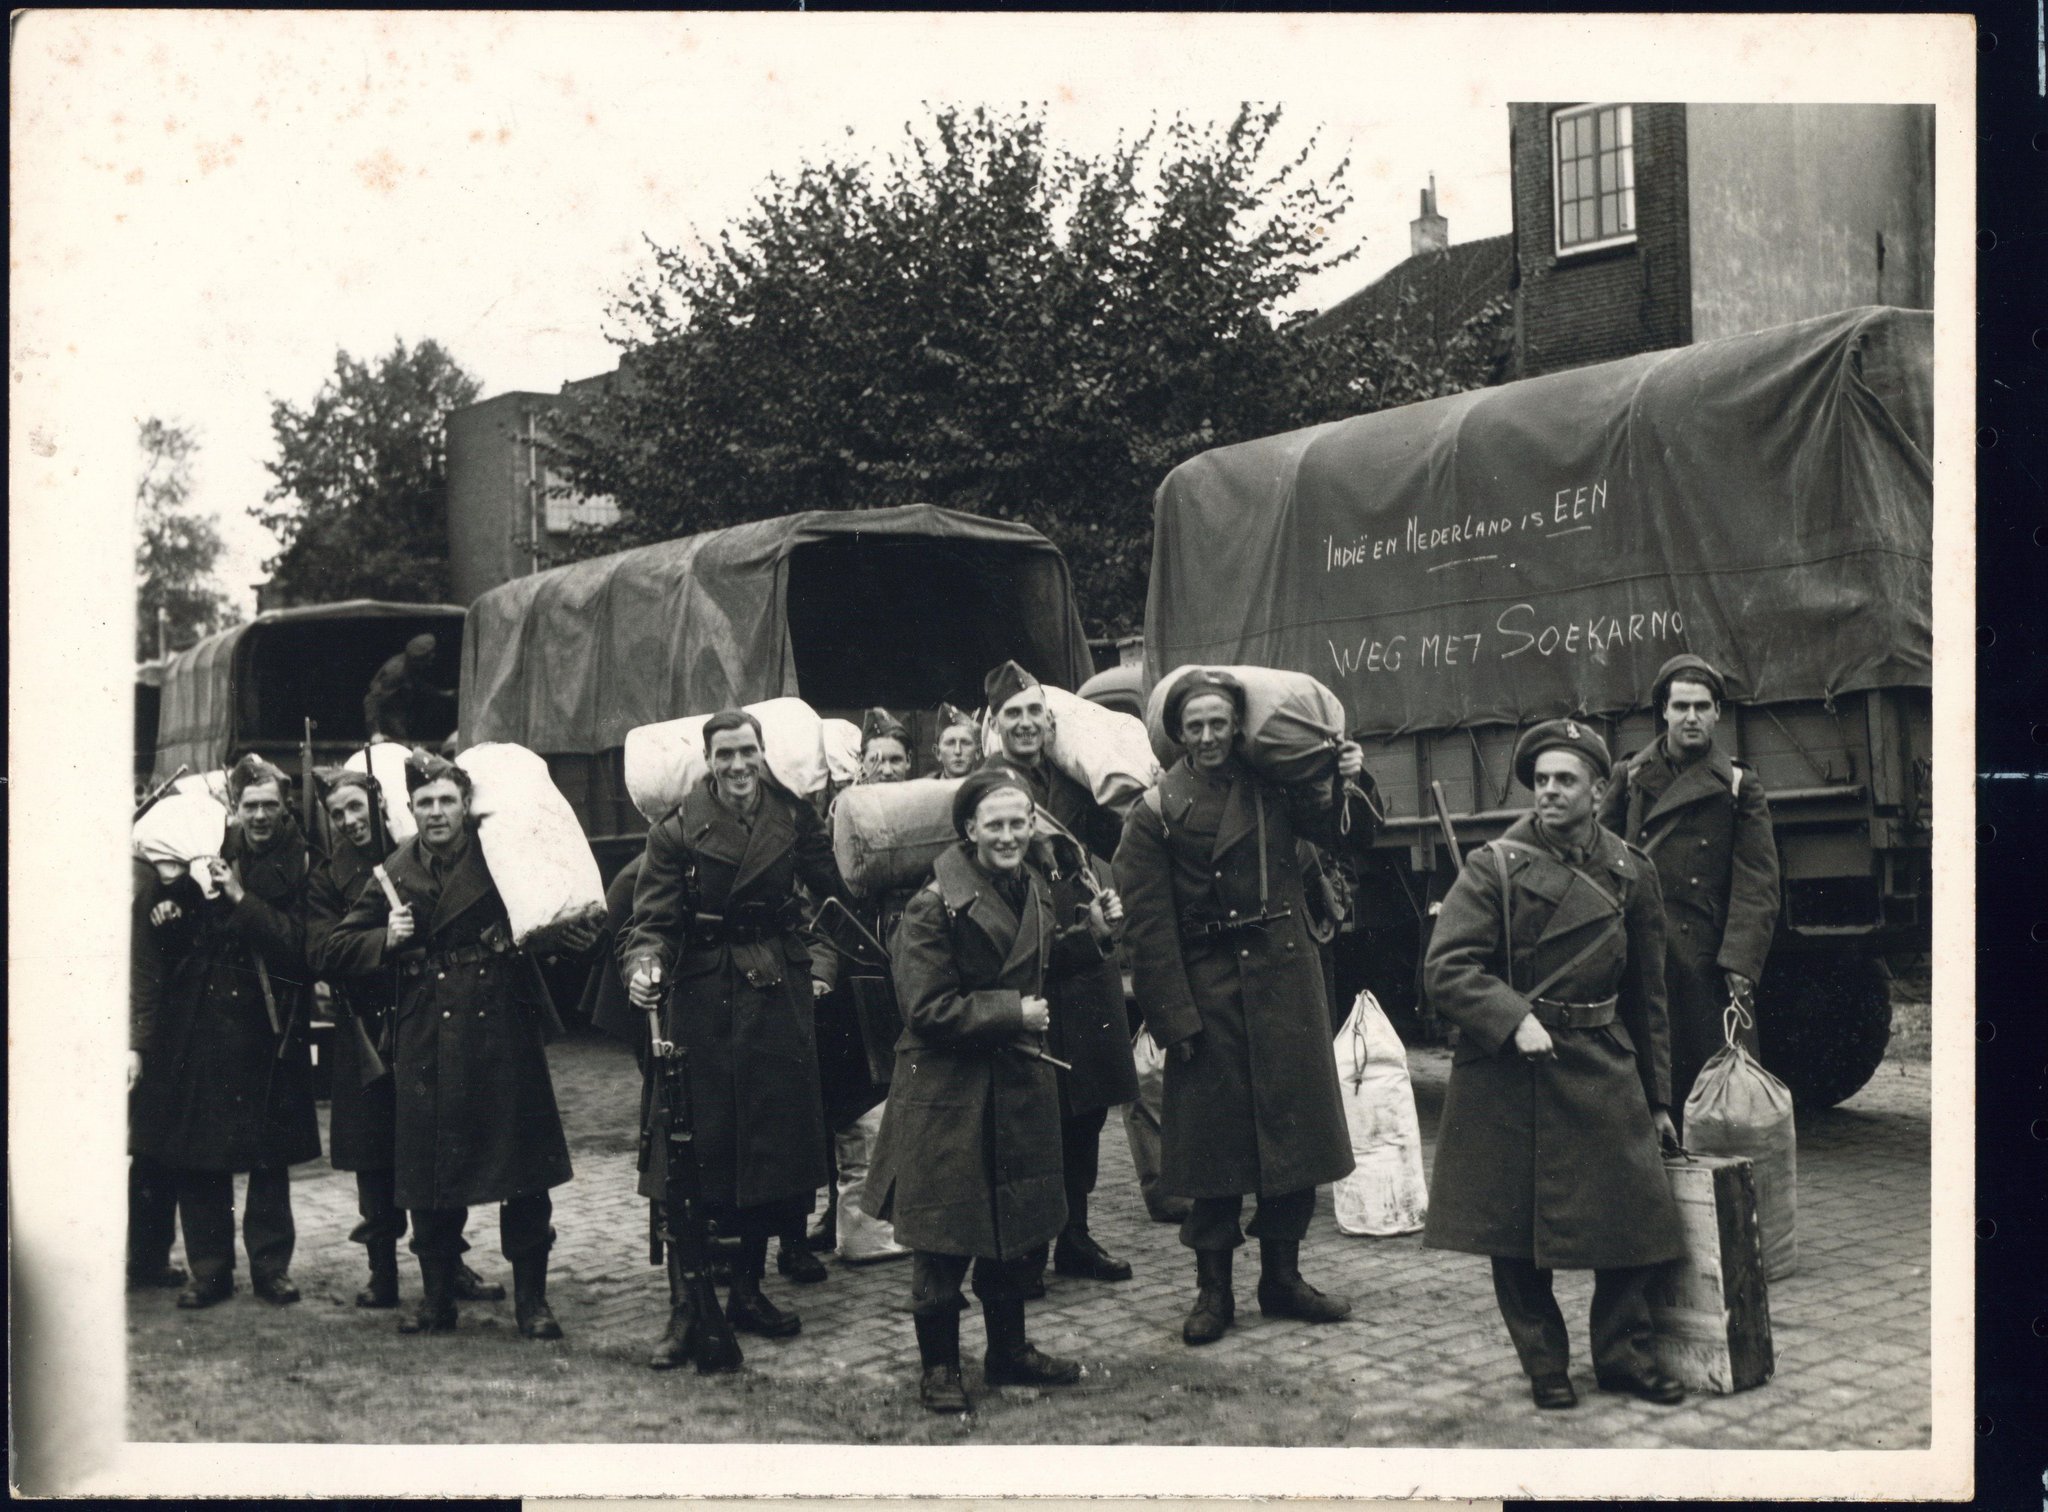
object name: documentary photograph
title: Militairen staande voor een vrachtwagen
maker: Anonymous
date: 1945-1949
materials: photographic support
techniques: photography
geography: netherlands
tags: surabaya, politician, indonesia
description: Een groep van elf militairen met geweren en plunjezakken staat gereed voor vertrek. Op één van de gereed staande vrachtwagens staat de volgende tekst: Indië en Nederland is EEN, Weg met Soekarno. Gezien de "Hollandse" achtergrond is deze foto waarschijnlijk genomen vlak voor vertrek naar Indië.